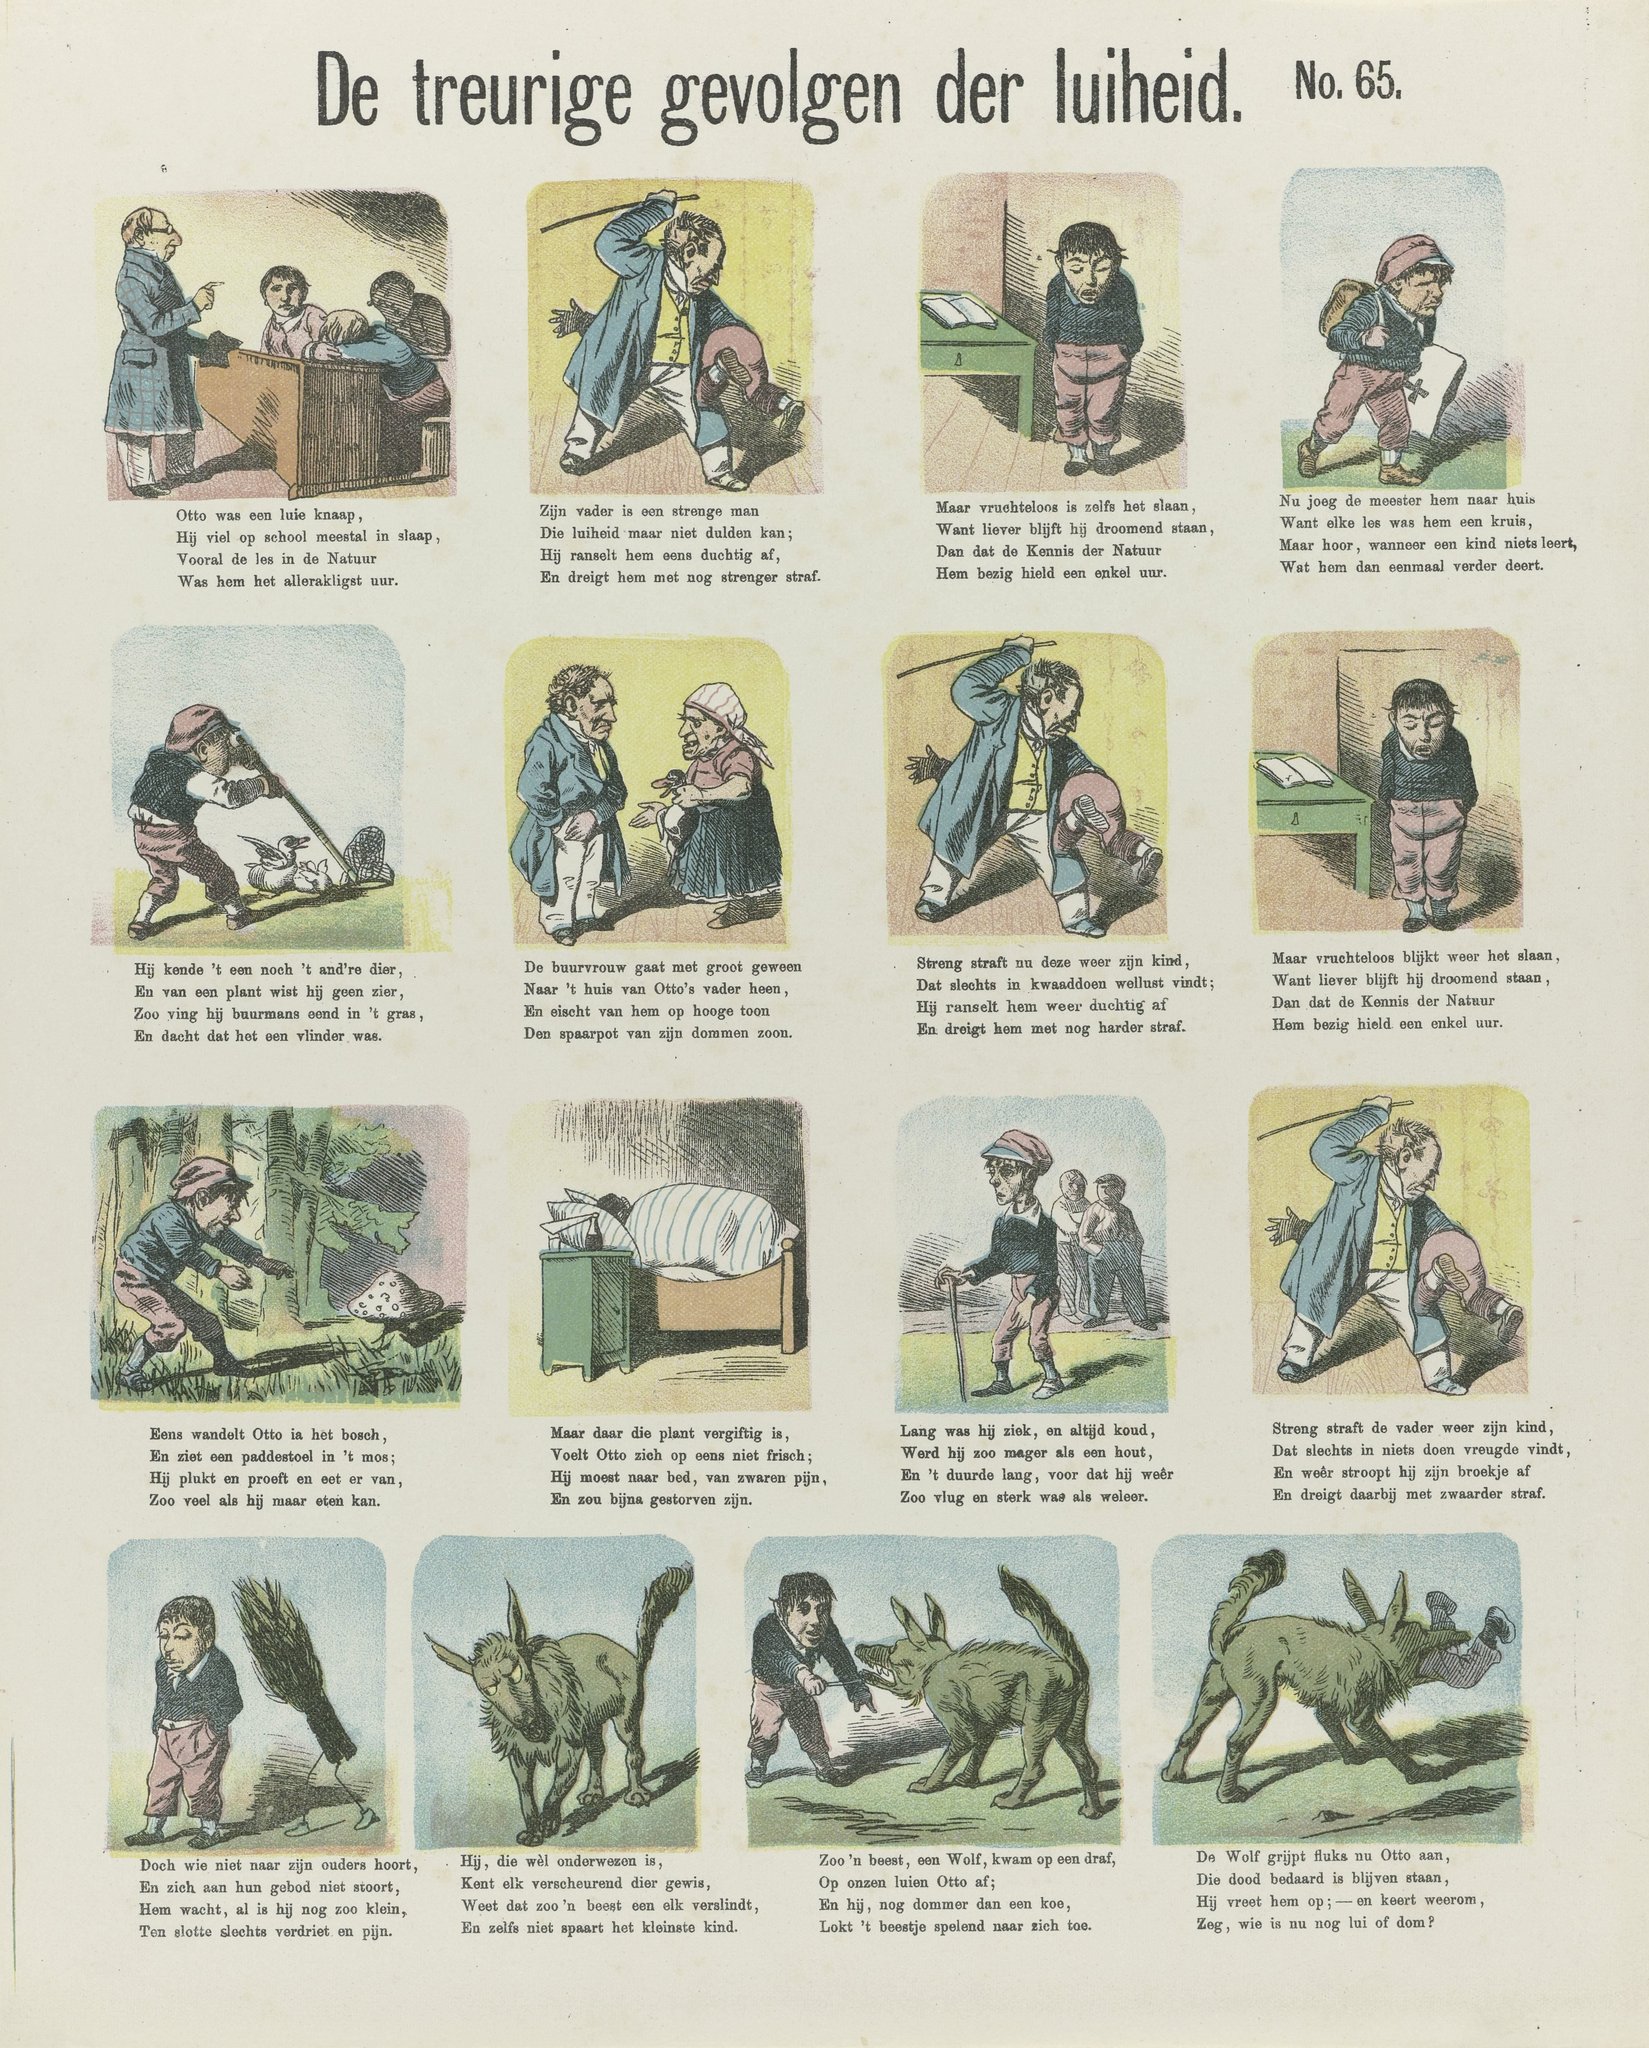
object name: print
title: Meijer's prenten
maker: Anonymous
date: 1878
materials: paper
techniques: lithograph, letterpress printing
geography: amsterdam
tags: correction of naughty children, child, bad behaviour, tales and fairy tales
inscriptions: collector's mark: Lugt 2760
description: Blad met 16 voorstellingen over het leven van het luie jongetje Otto. Onder elke afbeelding een vierregelig. Genummerd rechtsboven: No. 65.